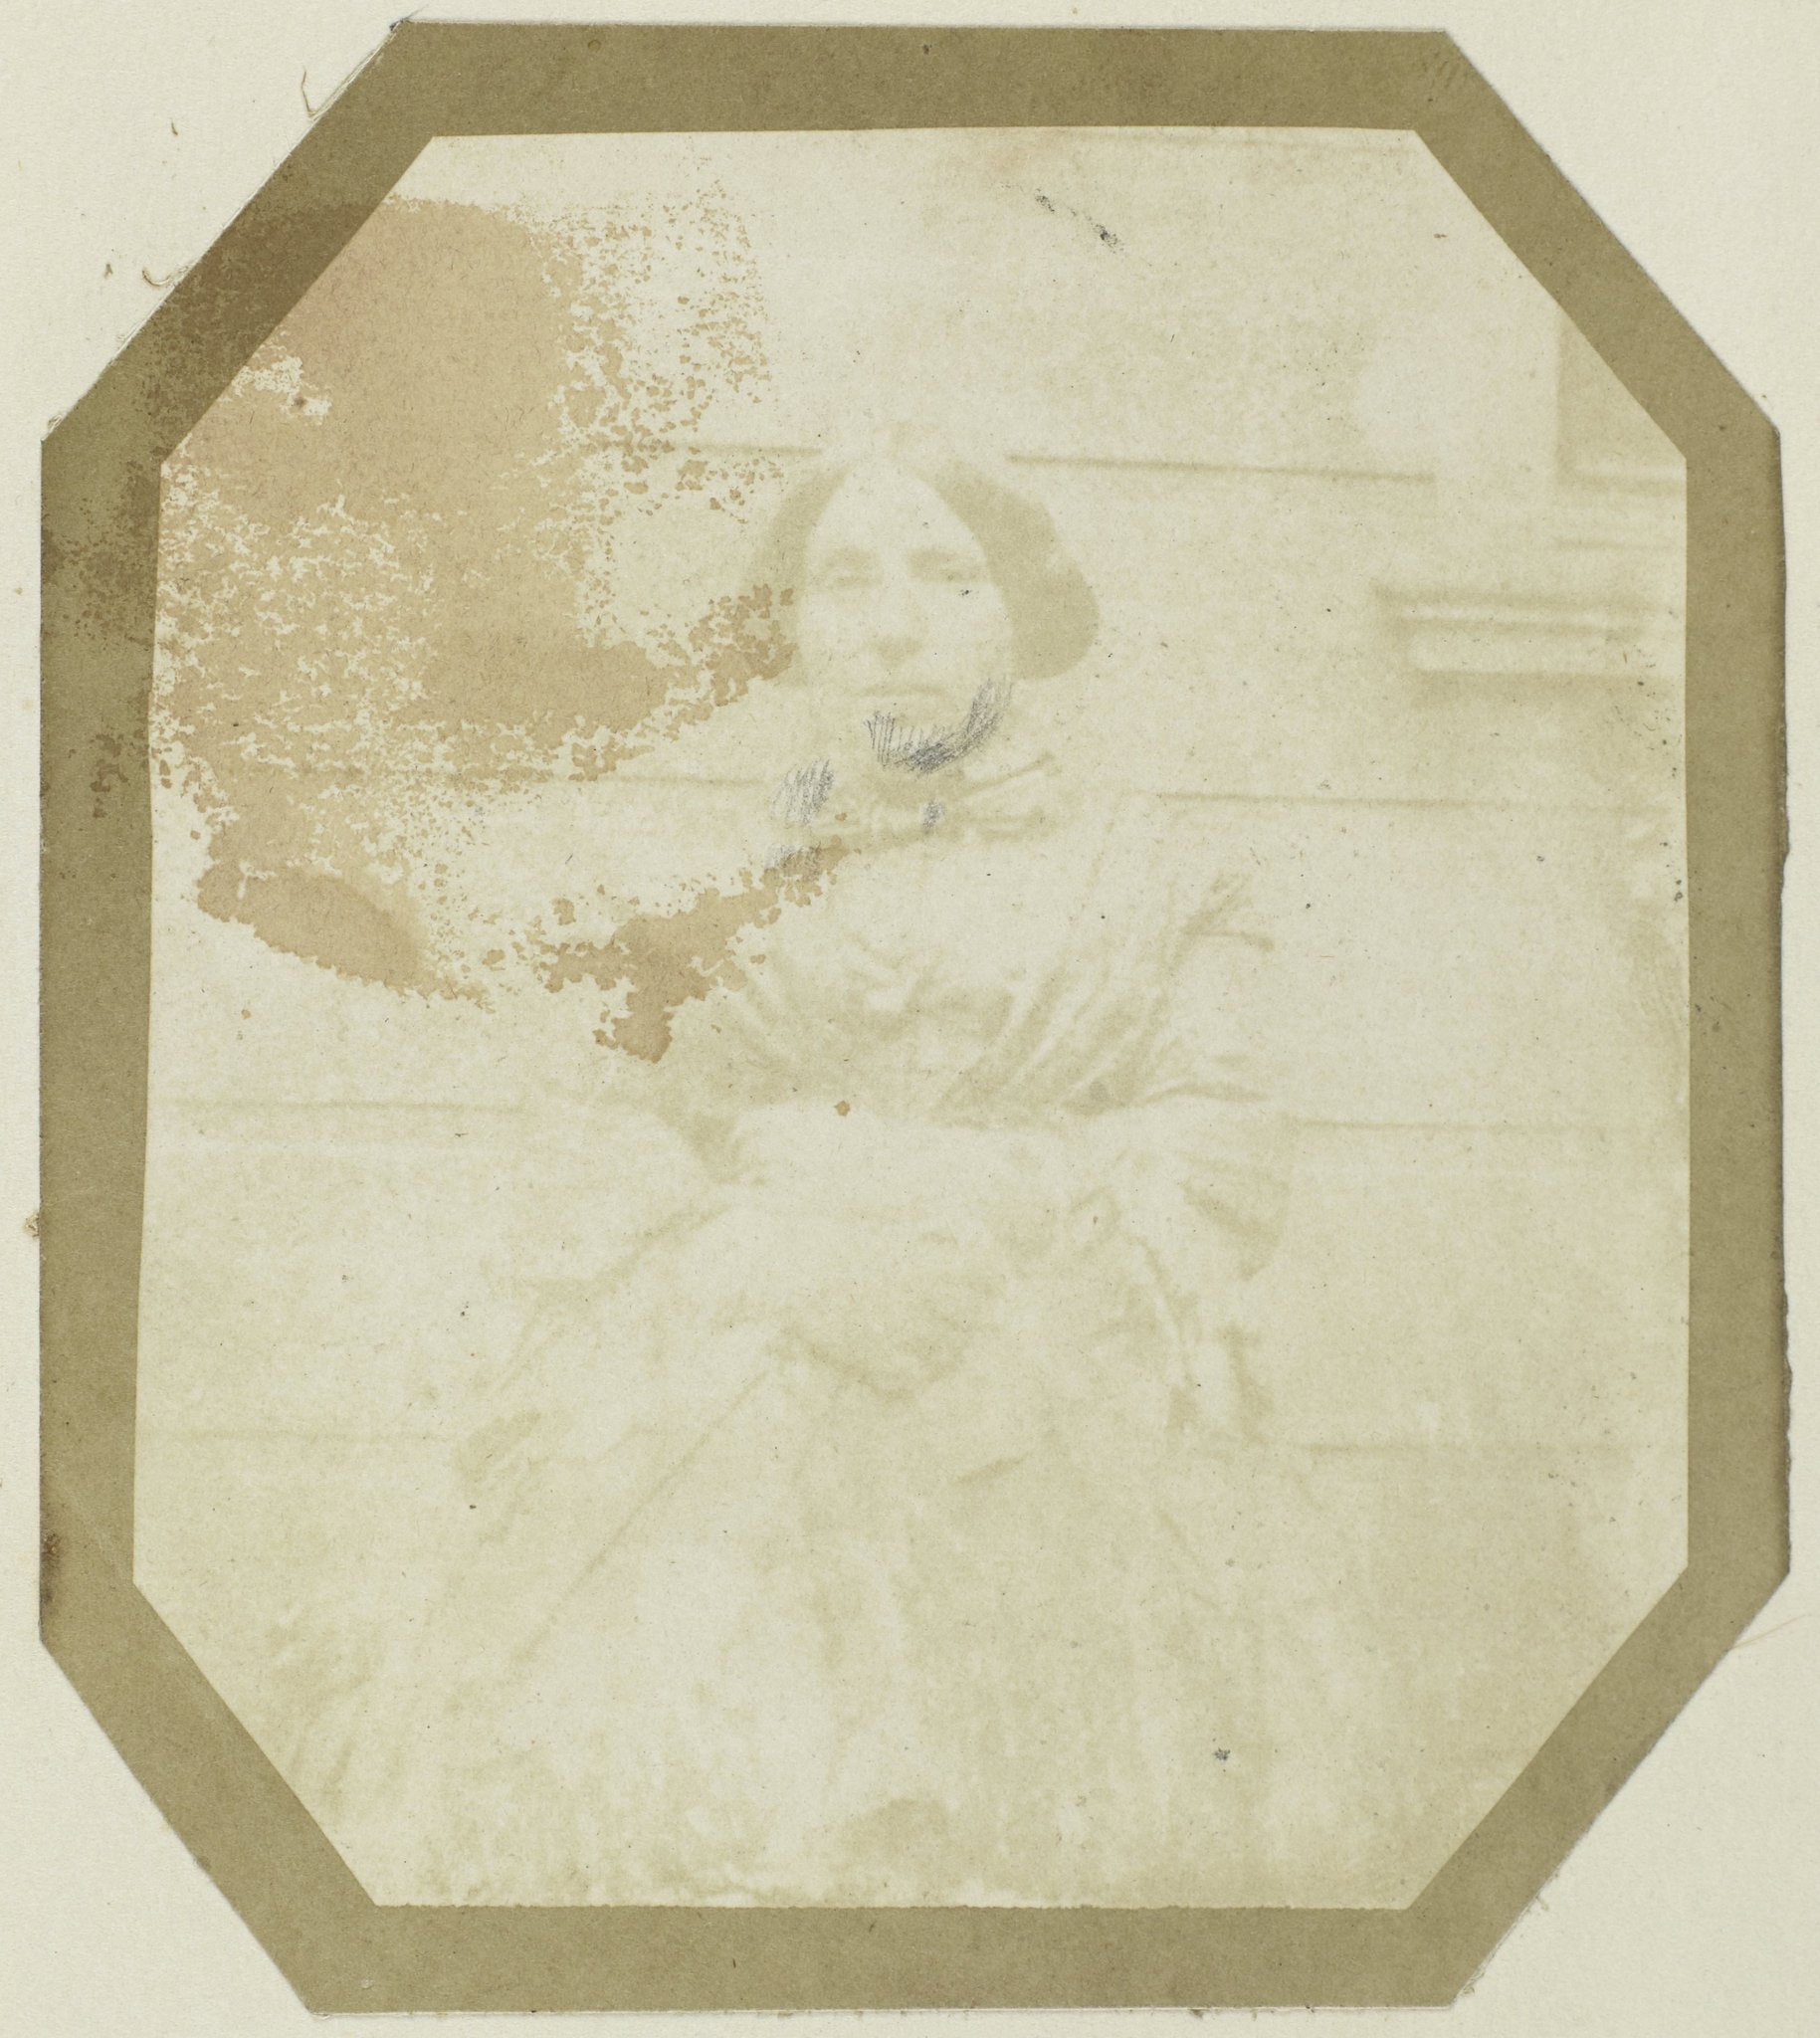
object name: photograph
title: Portret van een vrouw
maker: eduard isaac asser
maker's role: amateurfotograaf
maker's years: 1809-1894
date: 1846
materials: cardboard, paper, photographic support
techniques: salted paper print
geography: amsterdam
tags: historical persons - bb - woman, netherlands